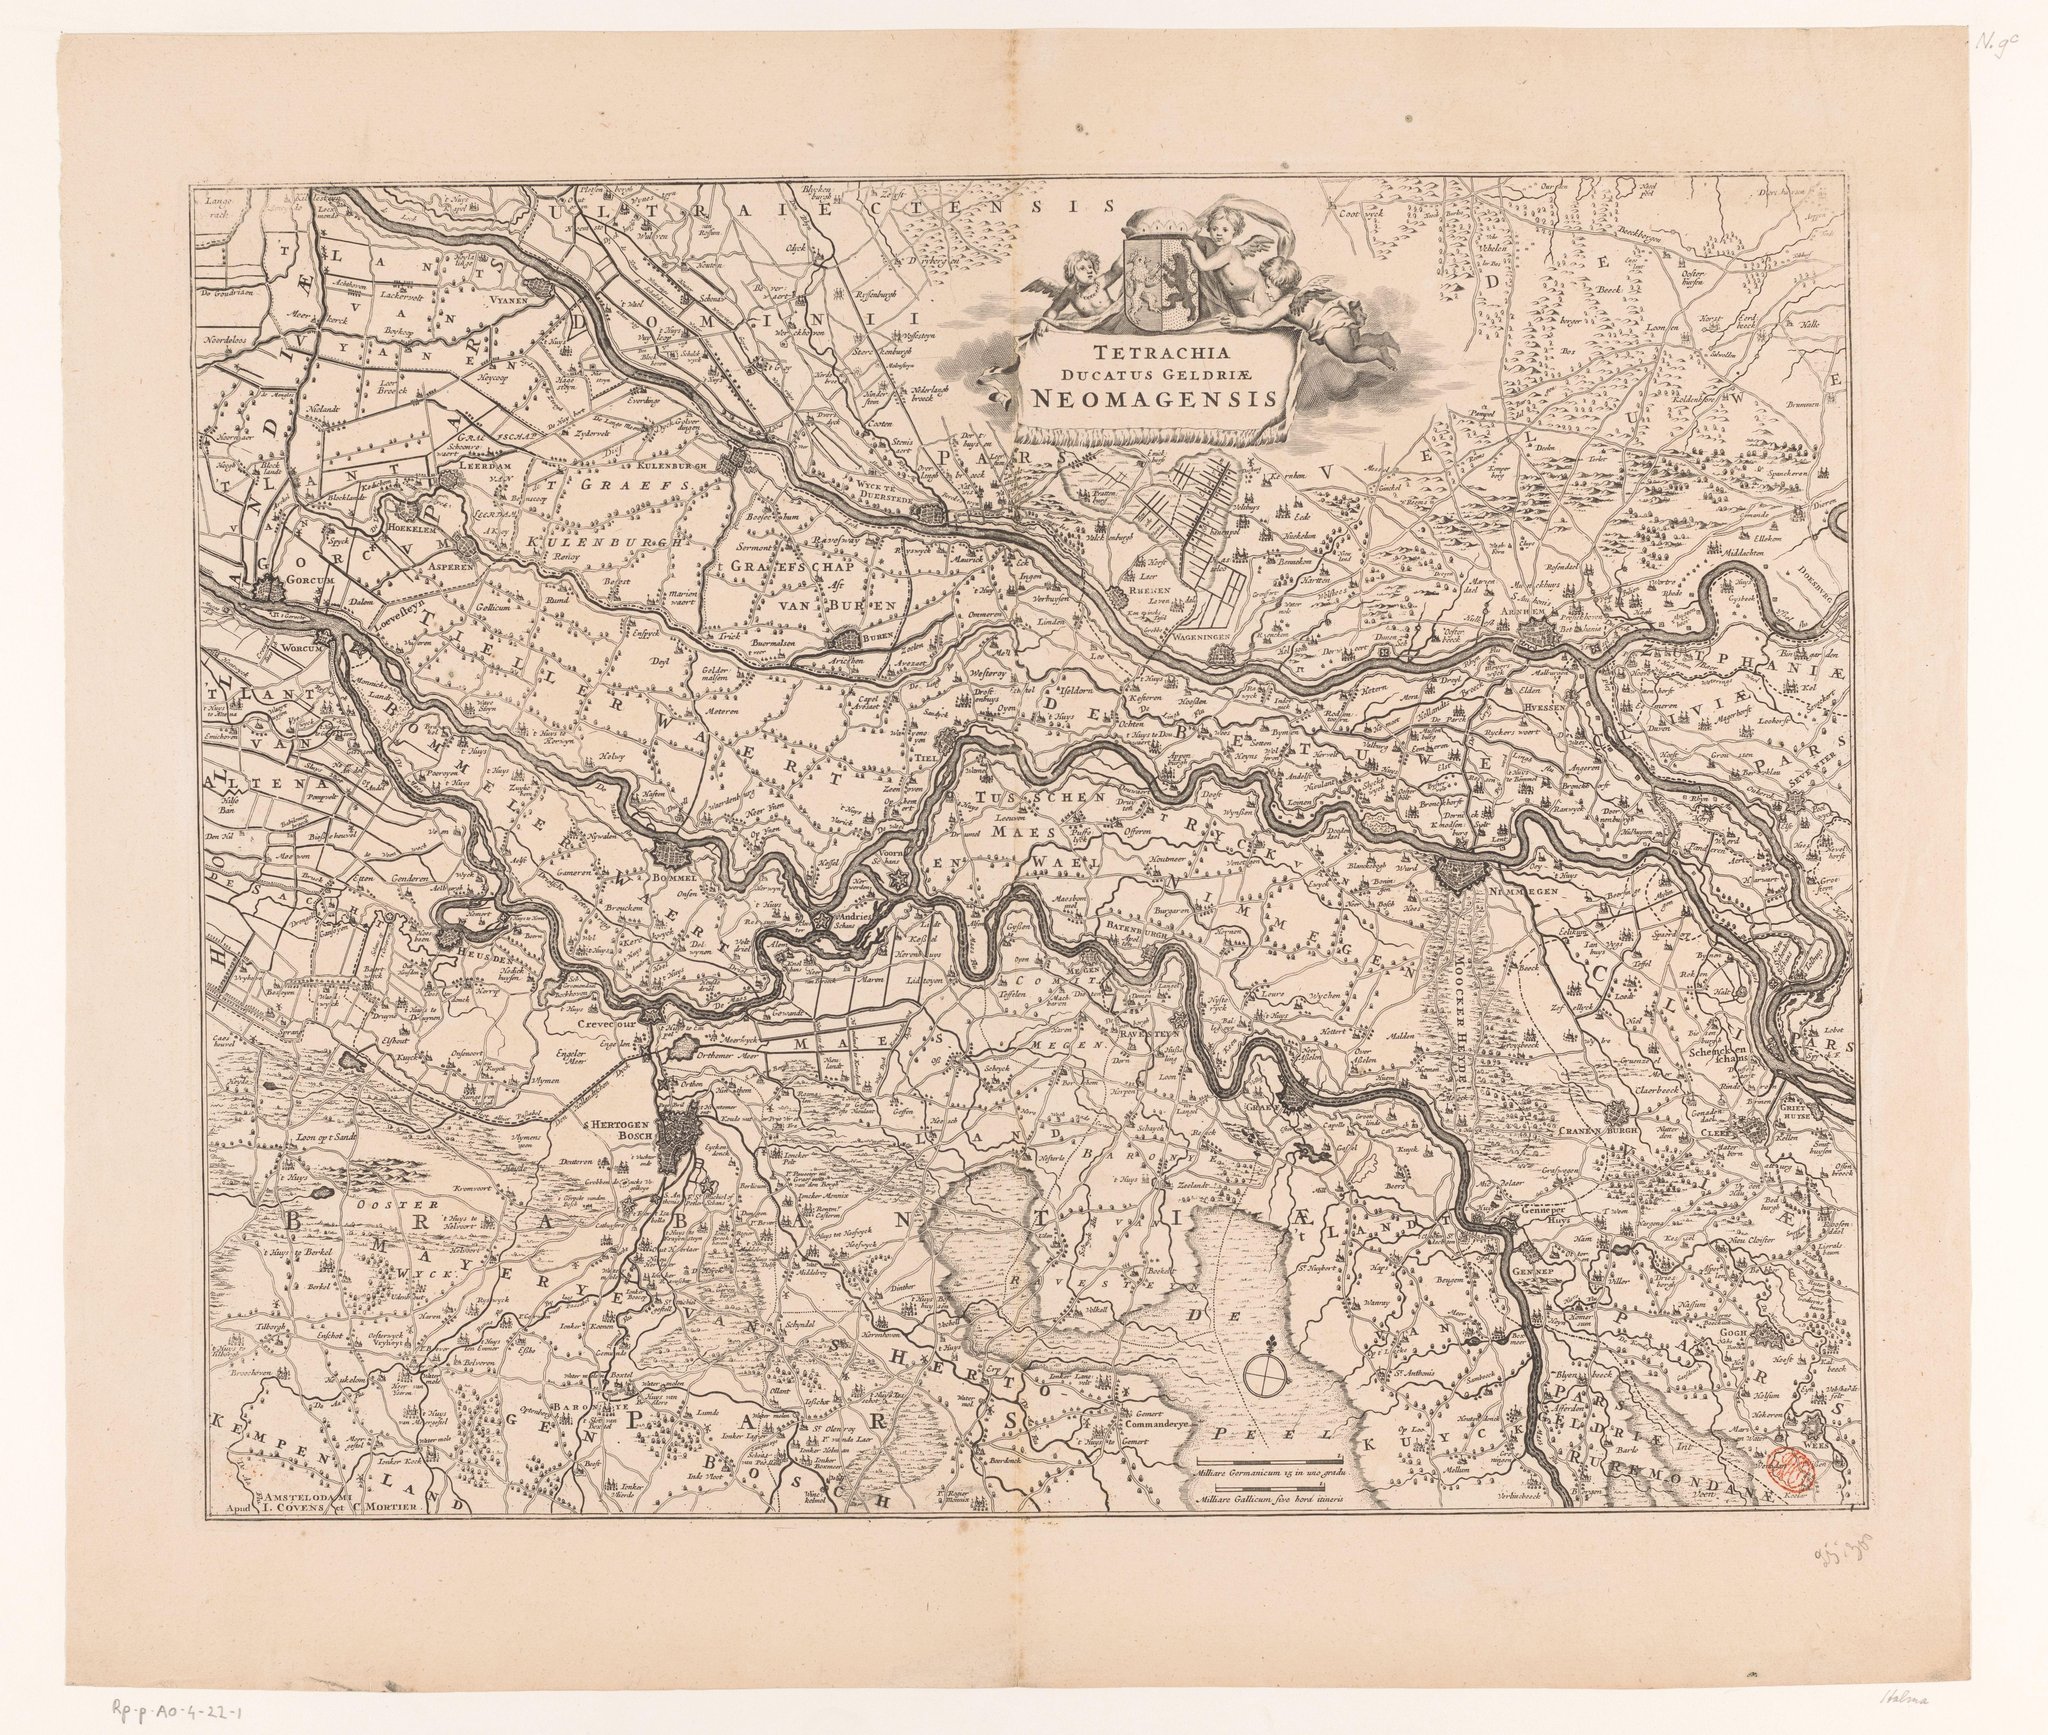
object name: print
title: Kaart van het Kwartier van Nijmegen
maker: Anonymous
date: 1750-1774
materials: paper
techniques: engraving, etching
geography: amsterdam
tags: maps of separate countries or regions, coat of arms (as symbol of the state, etc.) (+ province; provincial), nijmegen, gelderland, guelders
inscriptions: collector's mark: Lugt 195, collector's mark: Lugt 2228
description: Boven, rechts van het midden, de titelcartouche. Boven de cartouche putti met het wapen van Gelre. Onder, rechts van het midden, twee schaalstokken: 1 Milliare Germanicus 15 in uno gradu / 1 Milliare Gallicum sive hora itineris.